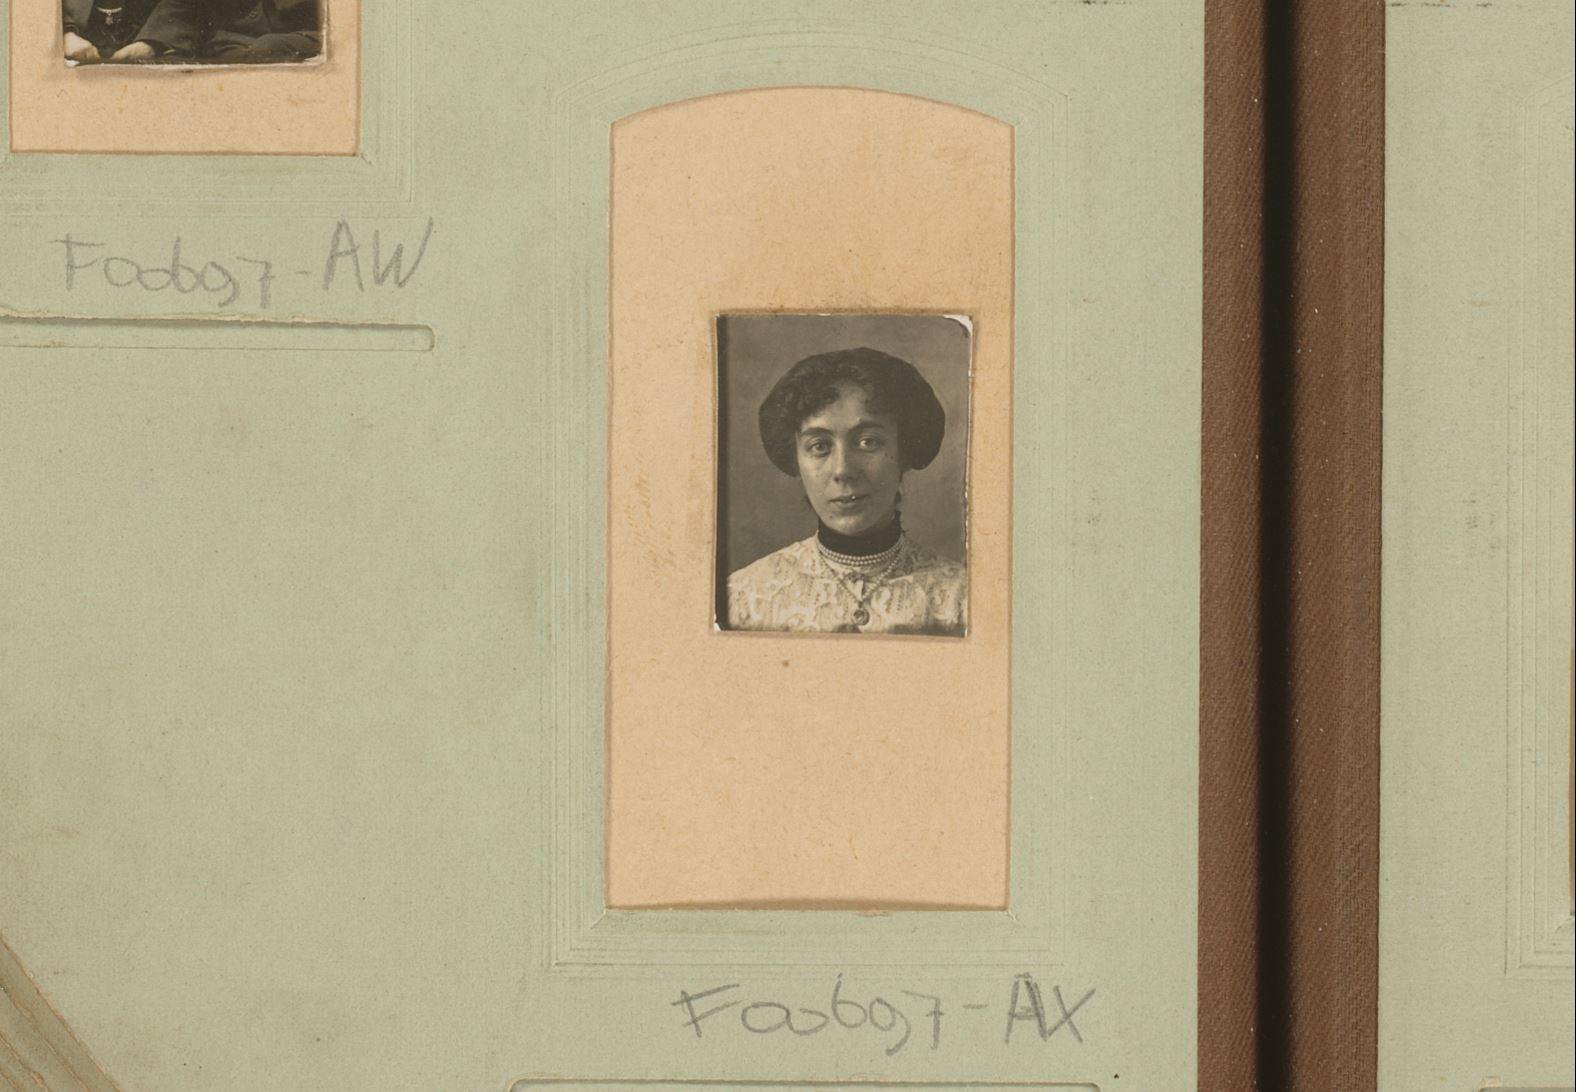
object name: album leaf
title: Portret van een vrouw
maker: Anonymous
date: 1890-1910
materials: photographic support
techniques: gelatin silver print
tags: adult woman, historical persons